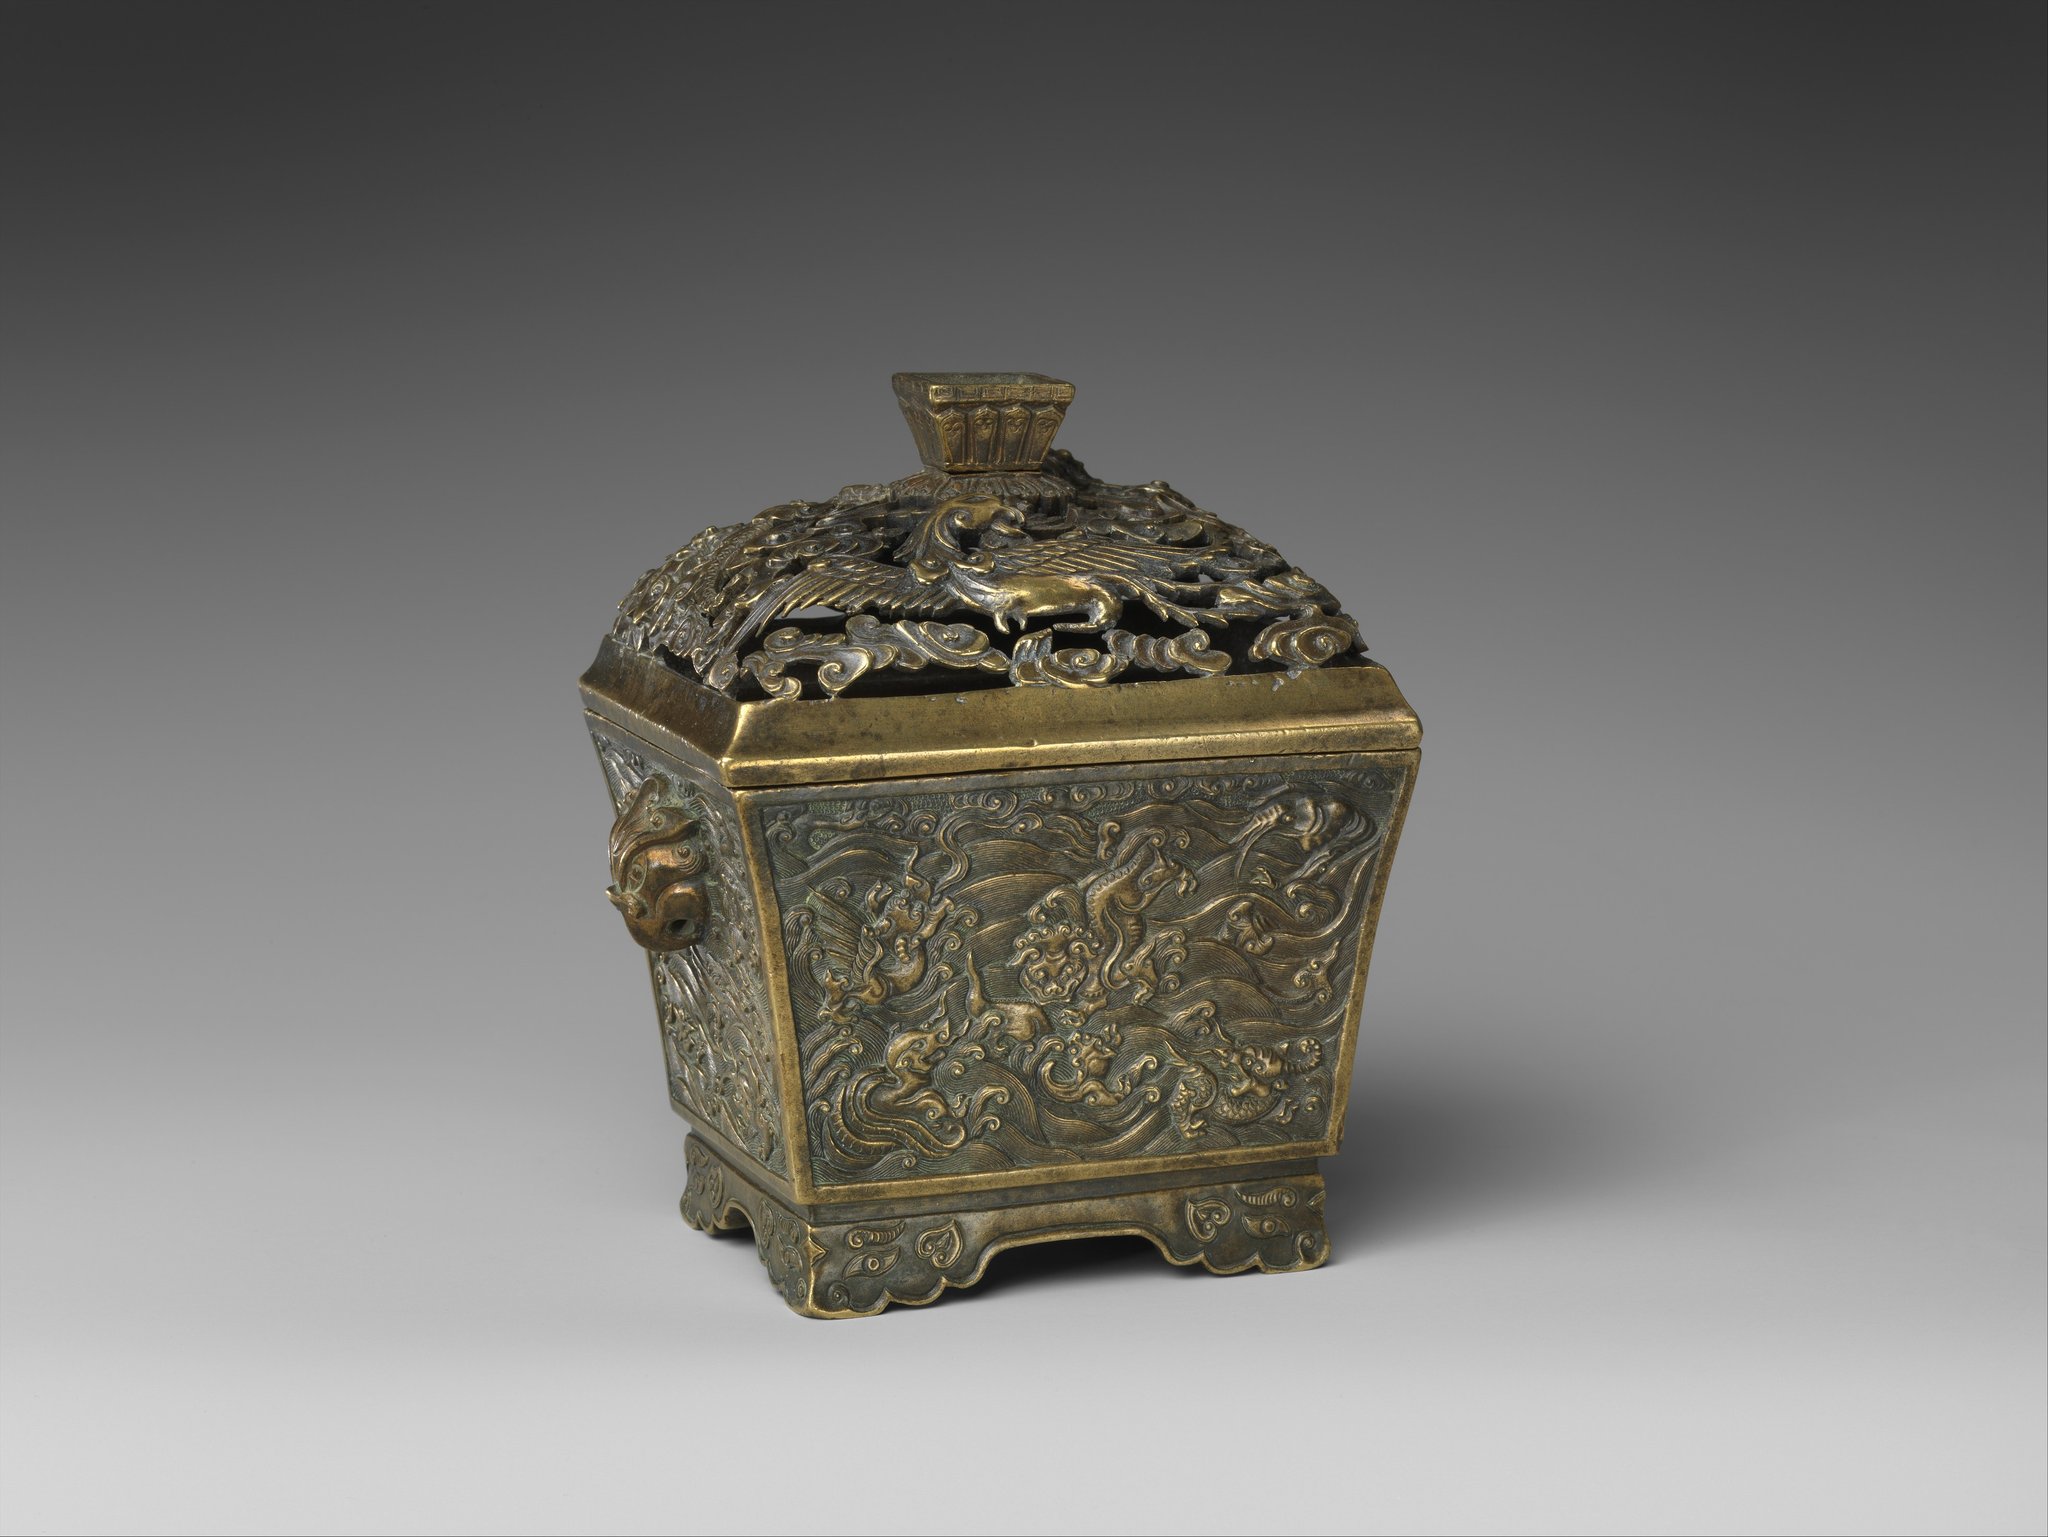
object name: incense burner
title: Incense burner with dragon, phoenix, and sea creatures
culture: chinese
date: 1501-1700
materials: copper alloy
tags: animals,dragons,waves